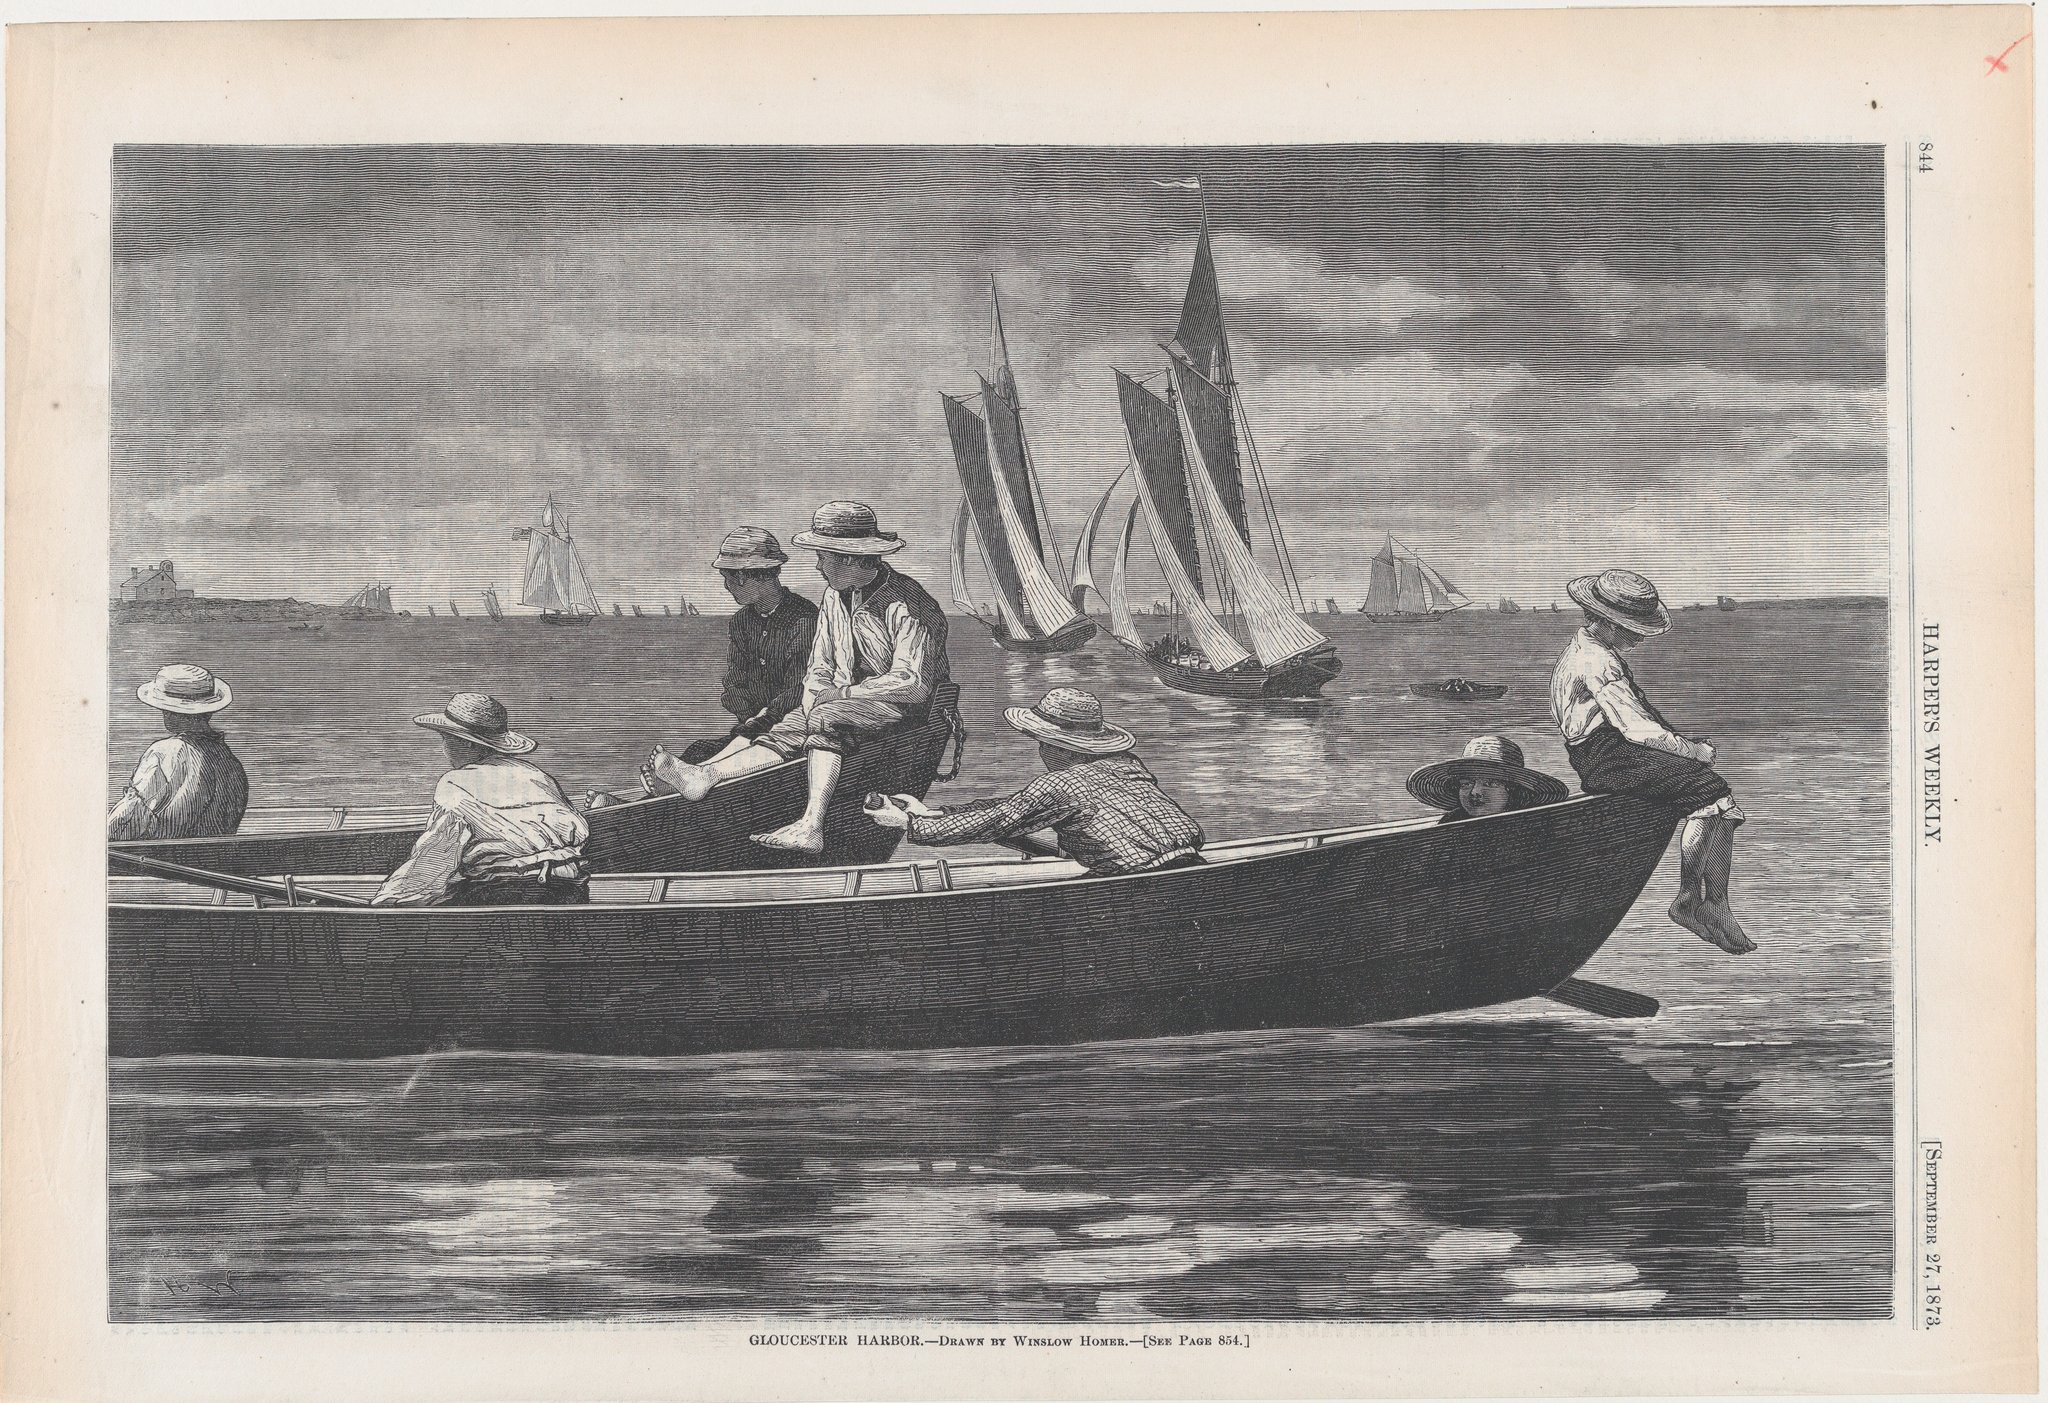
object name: print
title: Gloucester Harbor (from "Harper's Weekly," Vol. XVII)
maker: winslow homer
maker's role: artist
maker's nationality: american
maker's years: 1836-1910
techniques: engraving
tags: boys,boats